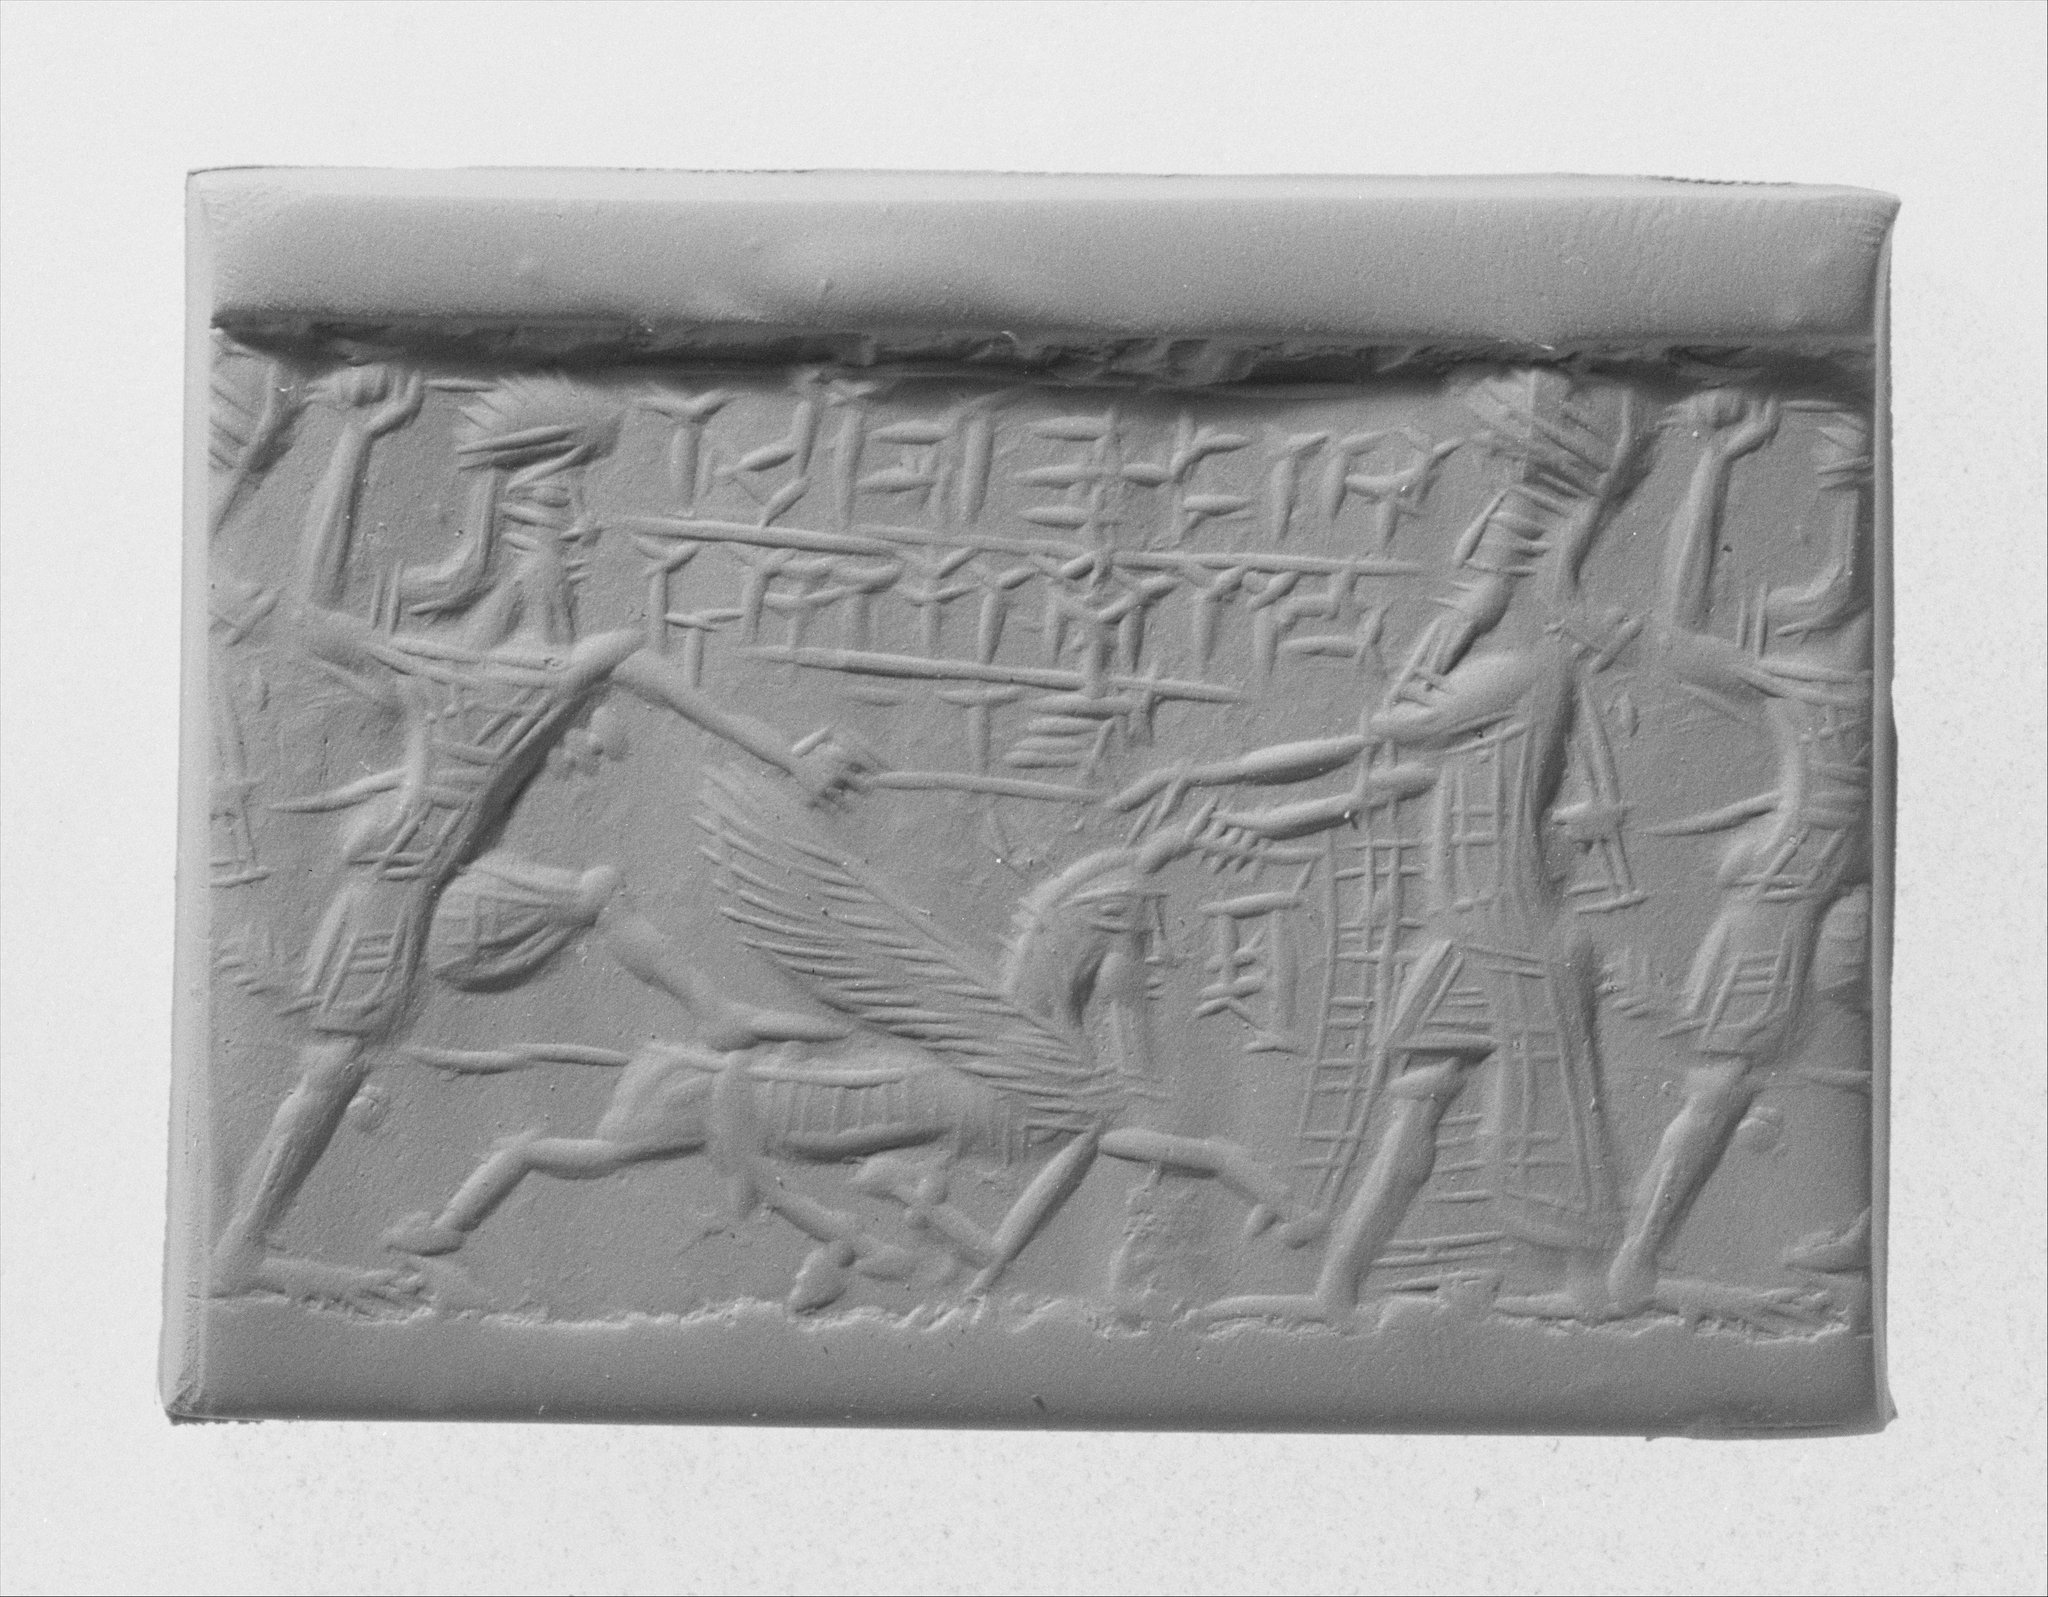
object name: cylinder seal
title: Cylinder seal with mythological contest scene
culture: babylonian or elamite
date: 834-768 BCE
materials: stone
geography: mesopotamia or iran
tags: men